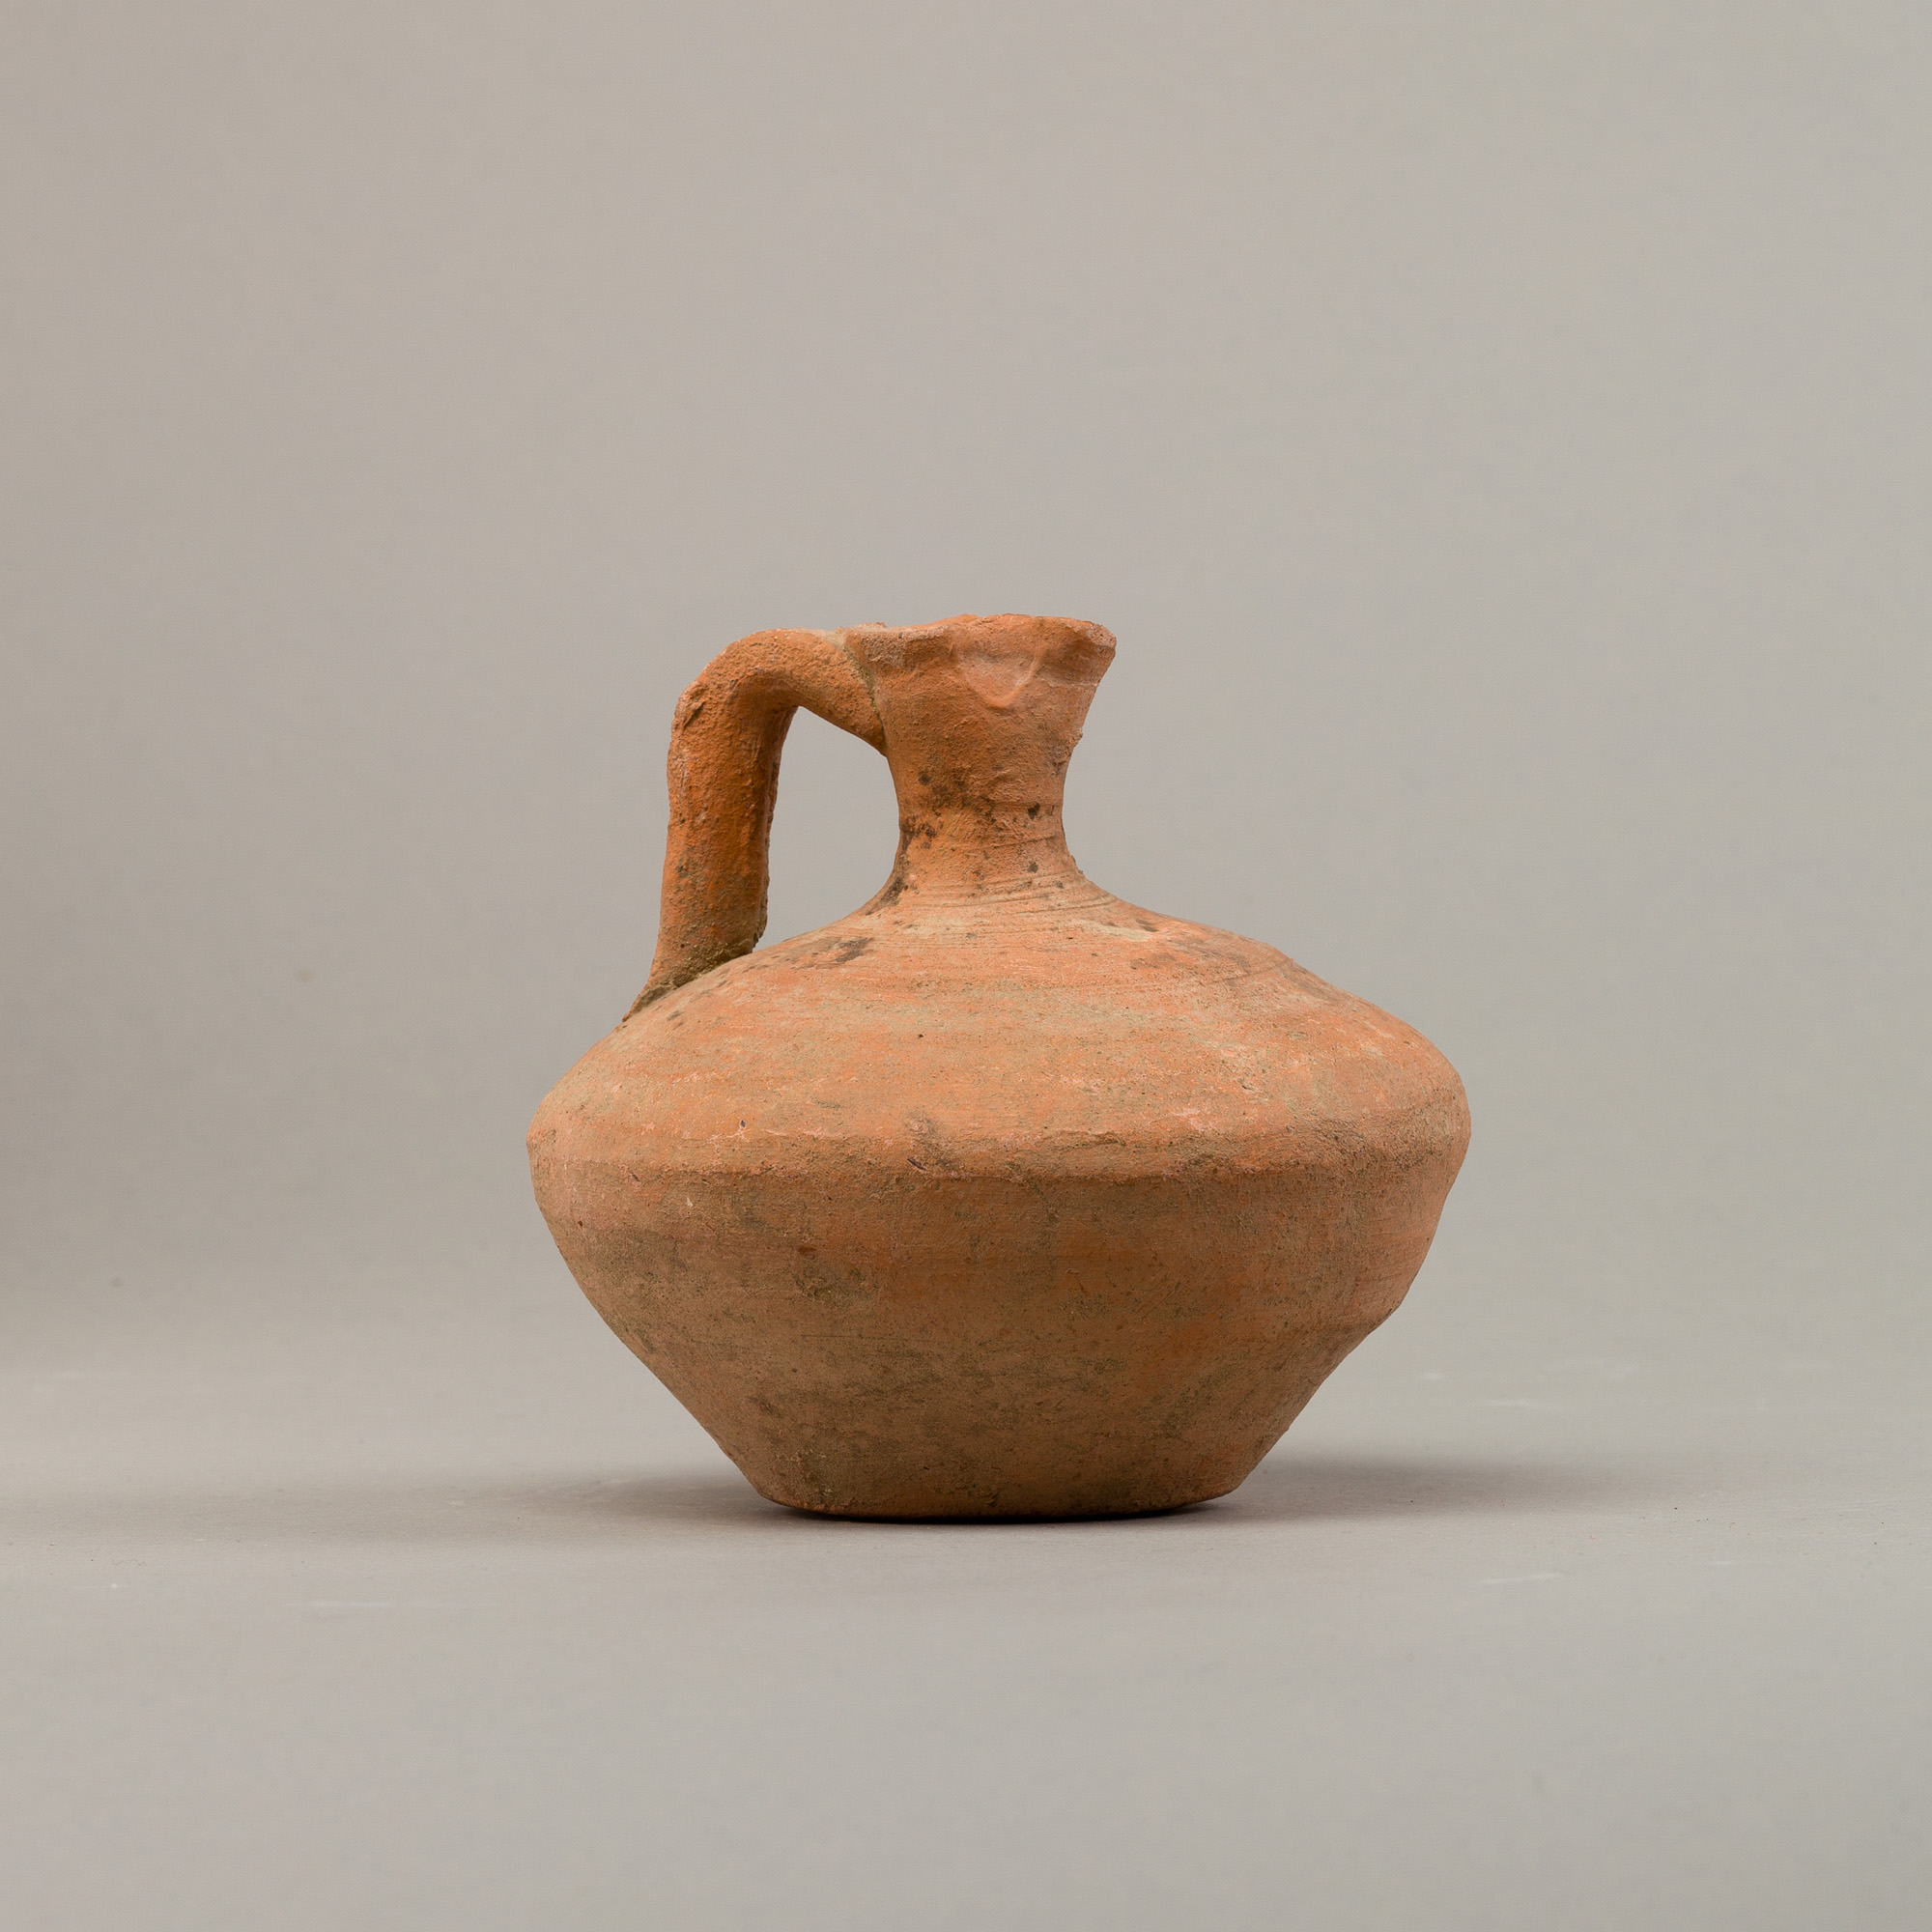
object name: jug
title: Jug with pinched trefoil rim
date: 1-200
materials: pottery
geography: egypt